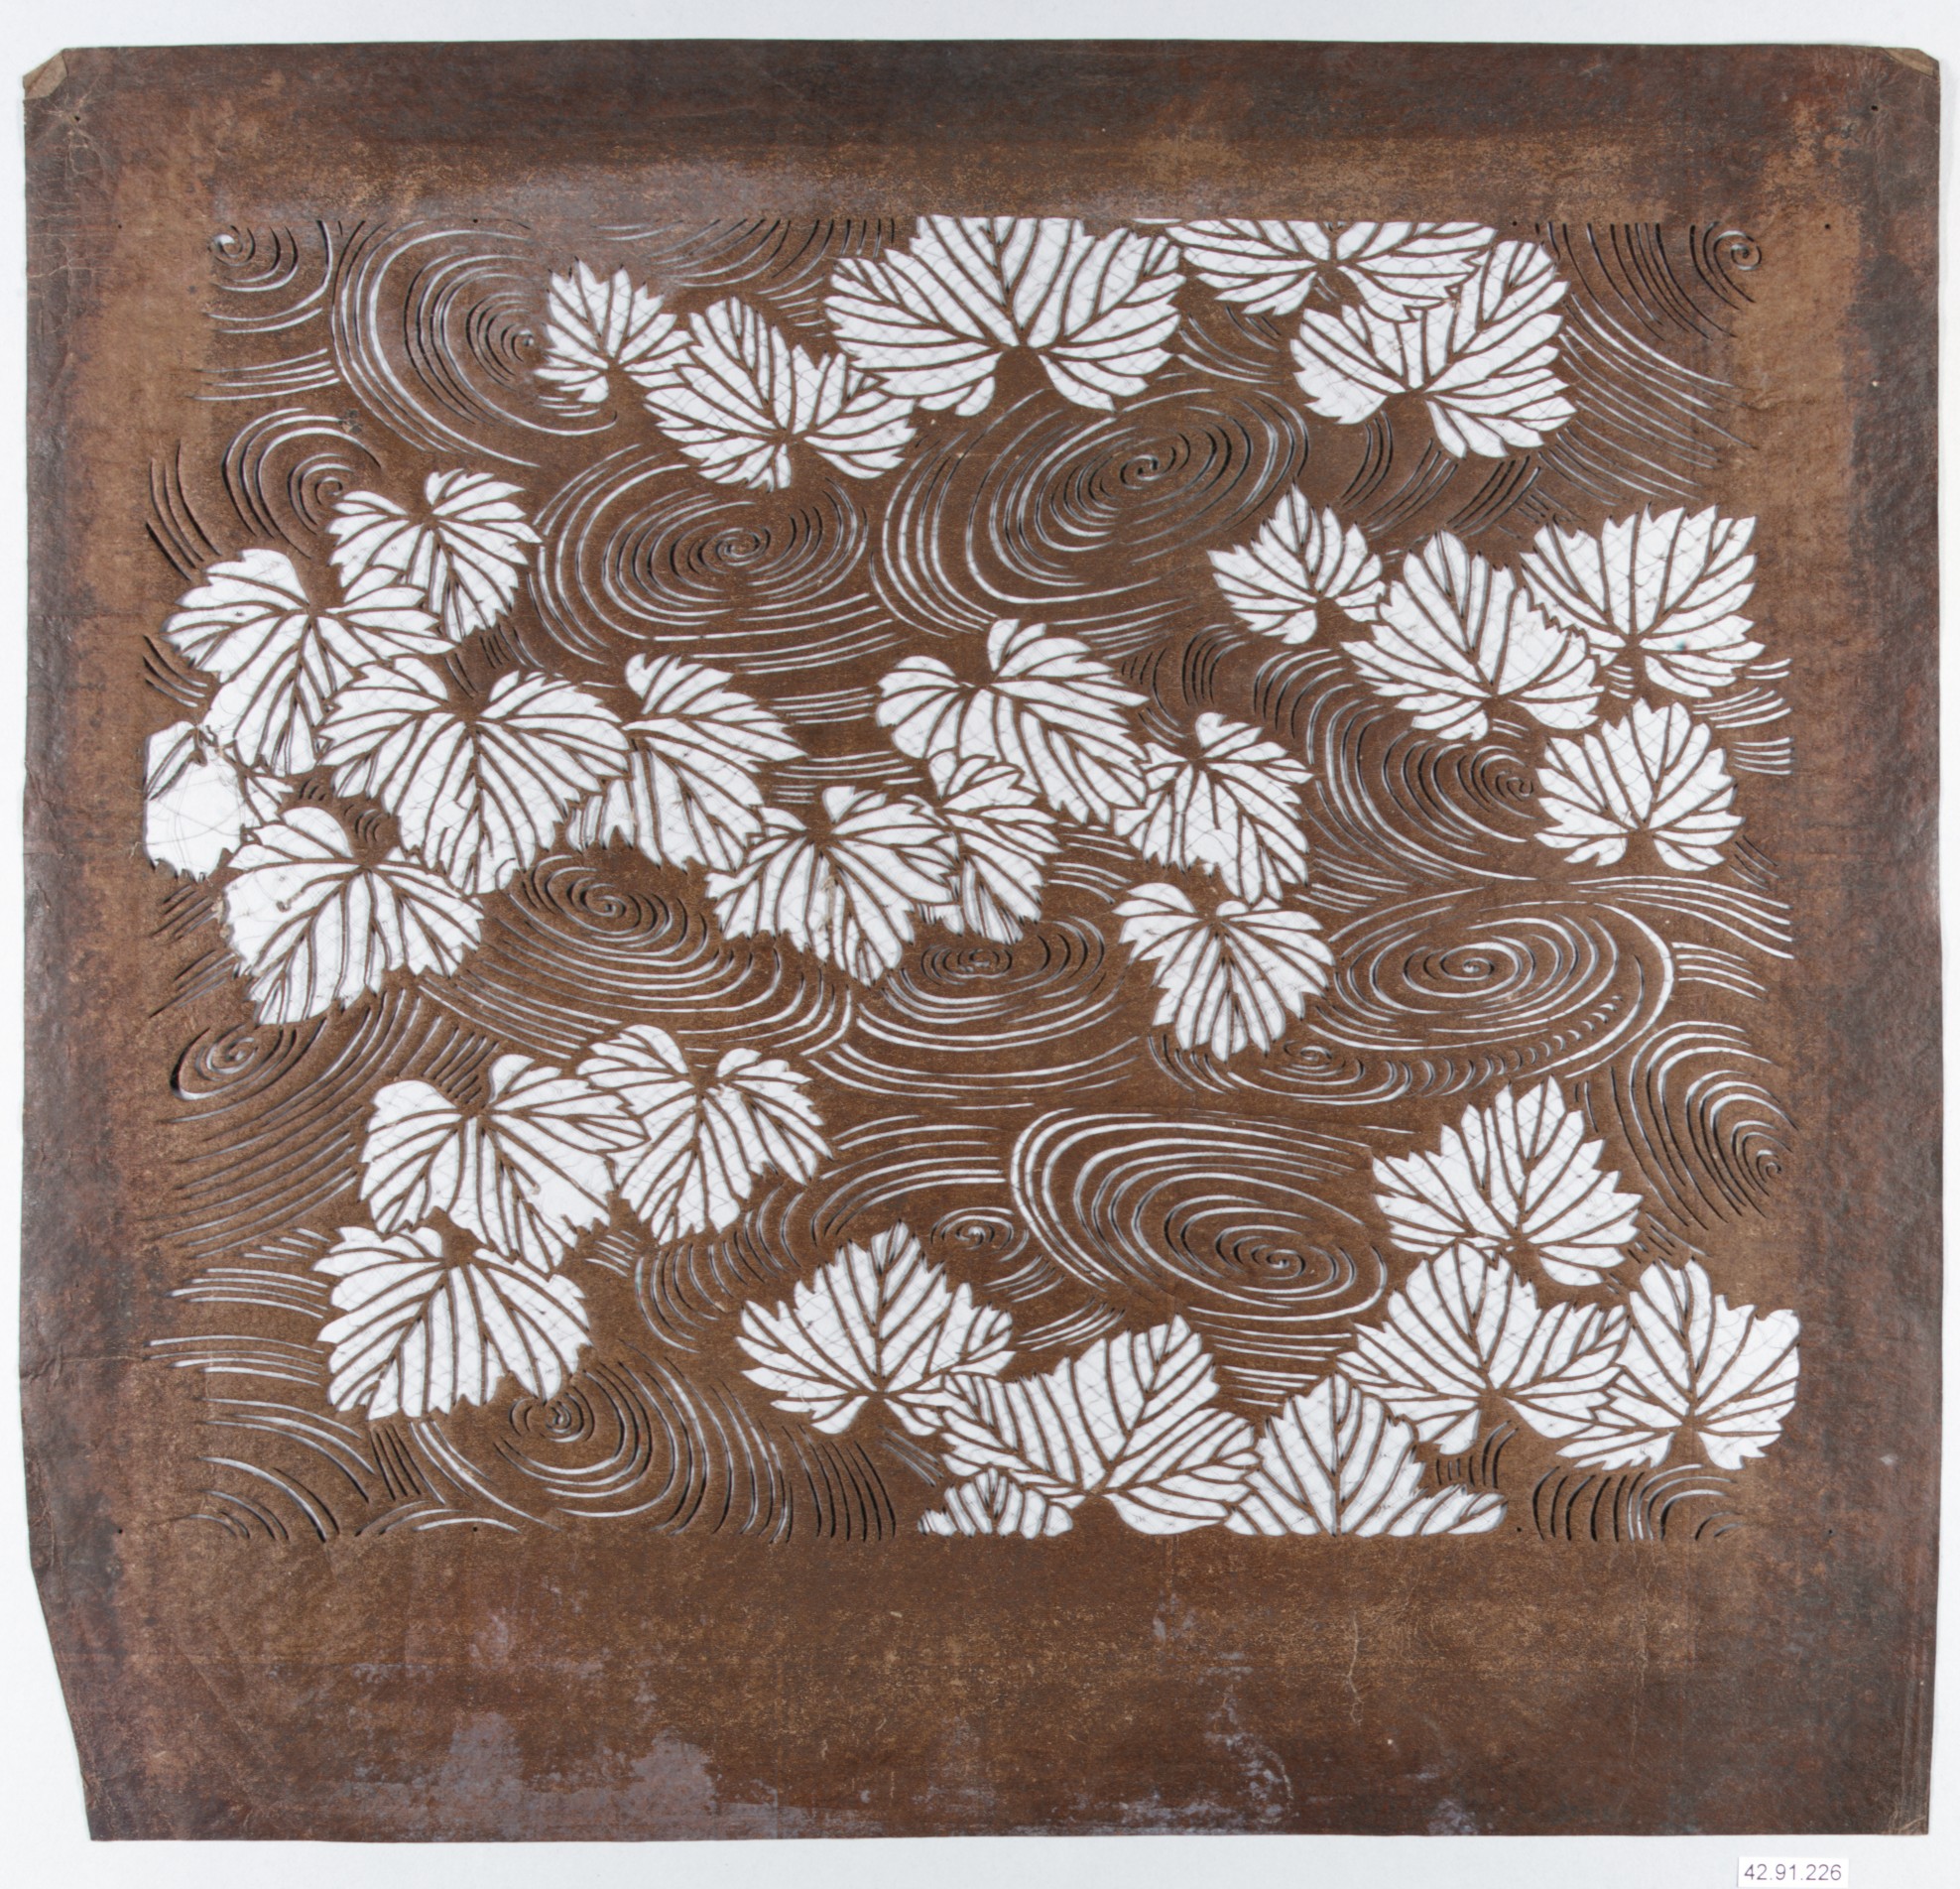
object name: stencil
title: Stencil with Pattern of Ivy Leaves on Water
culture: japanese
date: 1801-1900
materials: paper, silk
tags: leaves